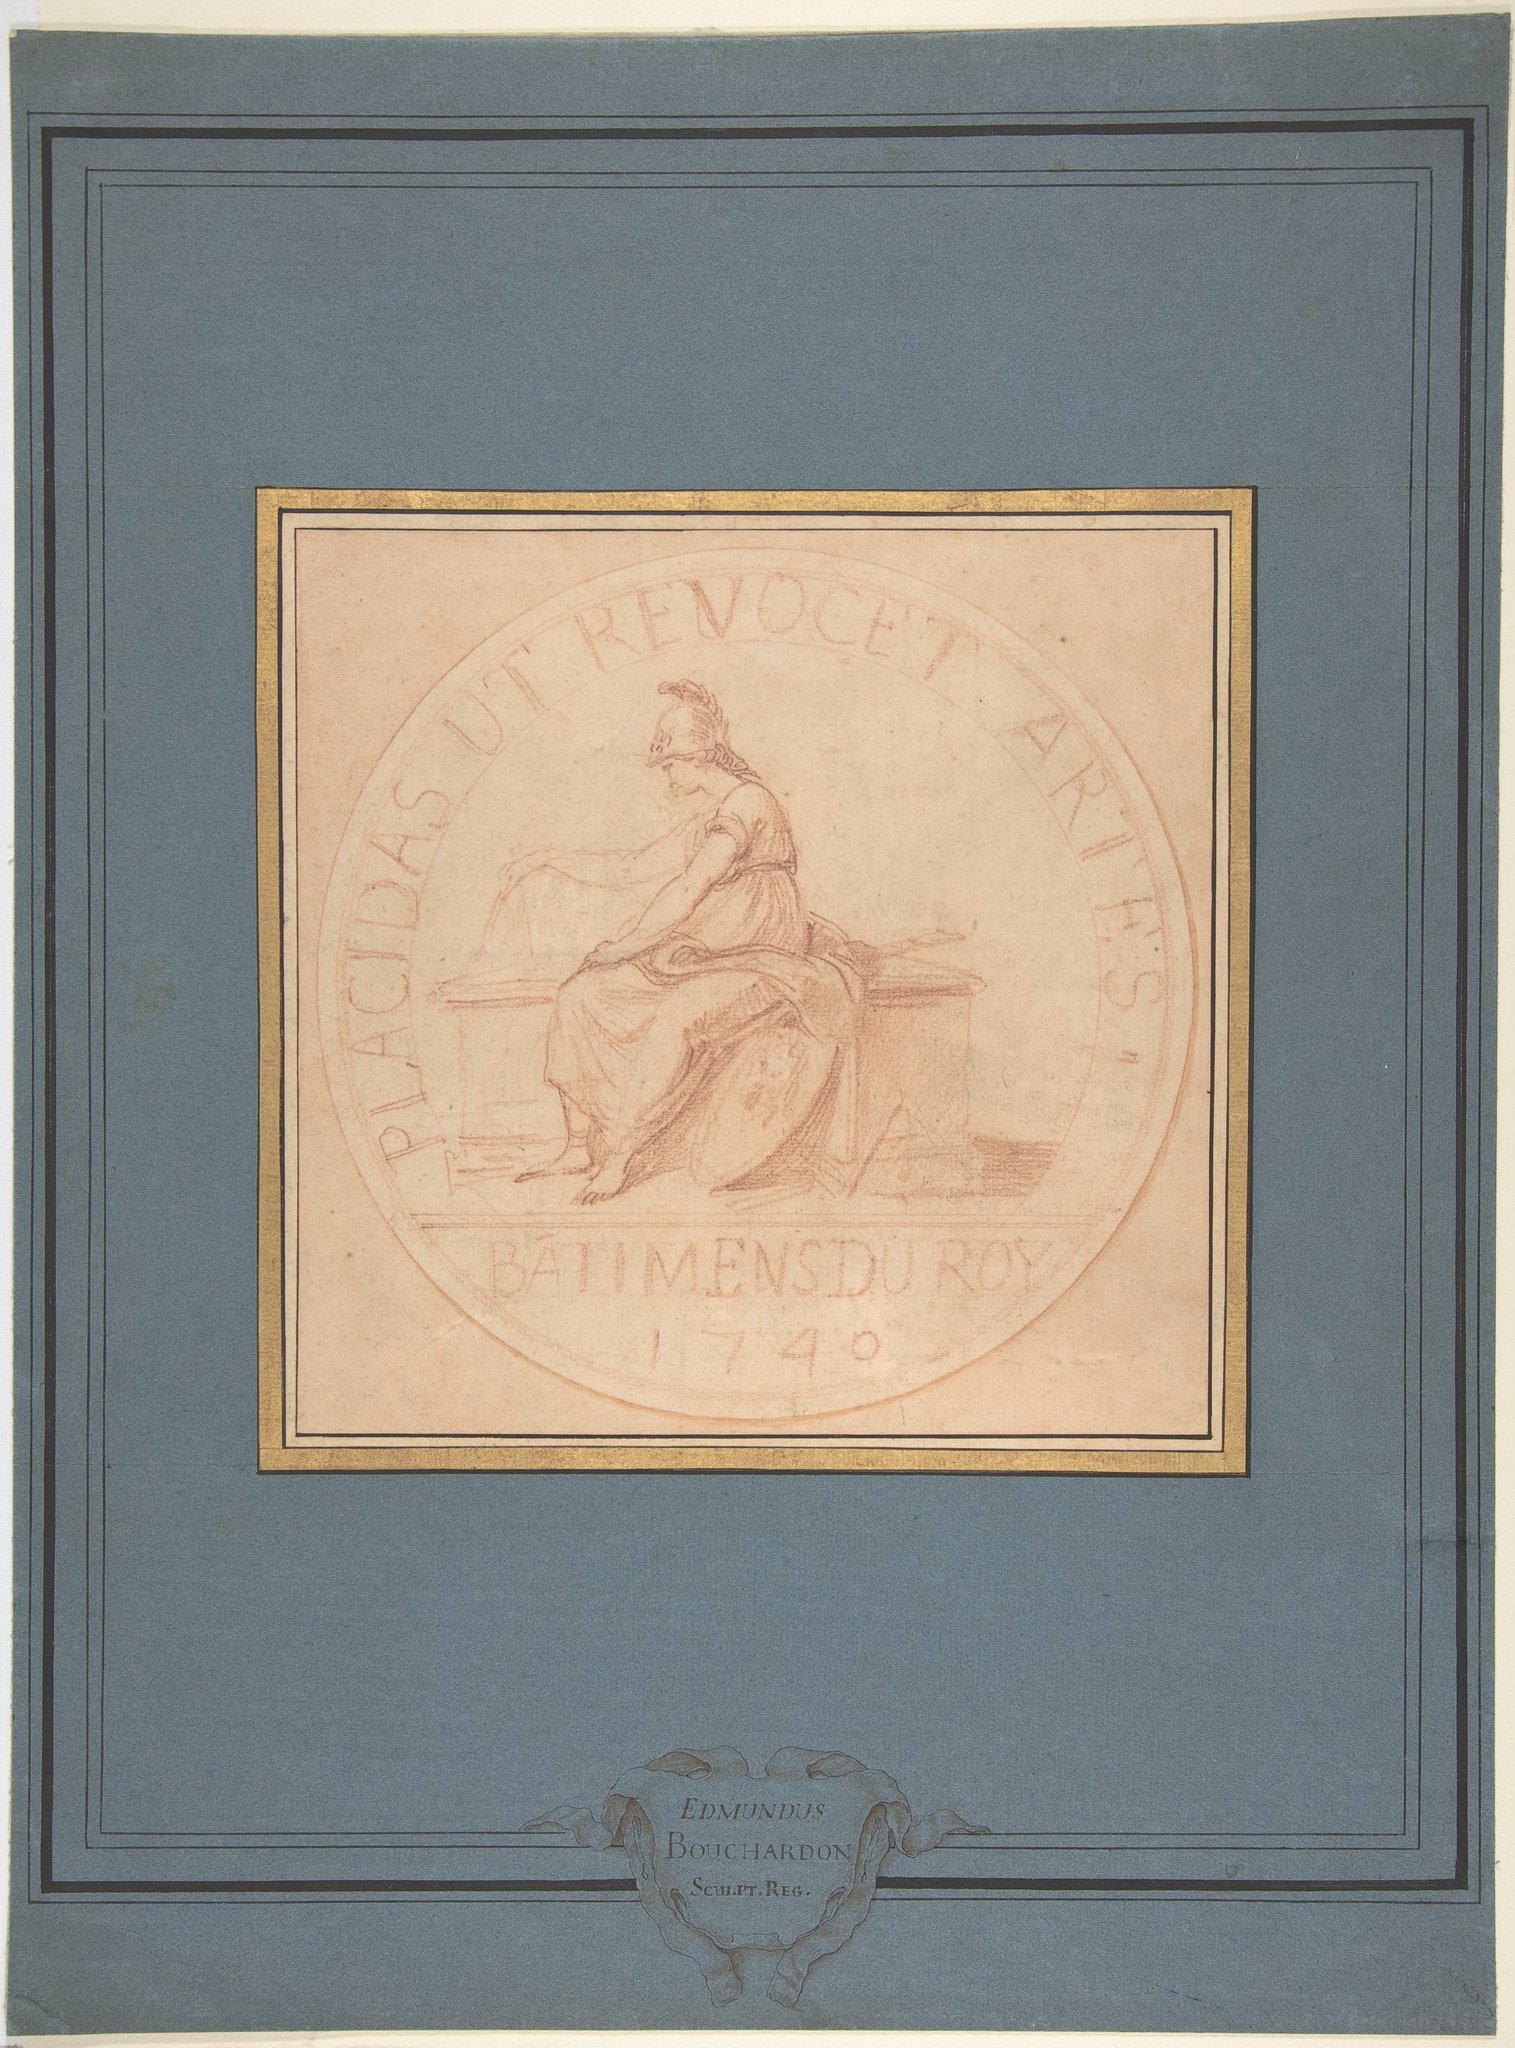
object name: drawing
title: Design for a Medal: Bâtiments du Roy, 1740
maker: edme bouchardon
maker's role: artist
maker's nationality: french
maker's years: 1698-1762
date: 1701-1800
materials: chalk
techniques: wash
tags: human figures